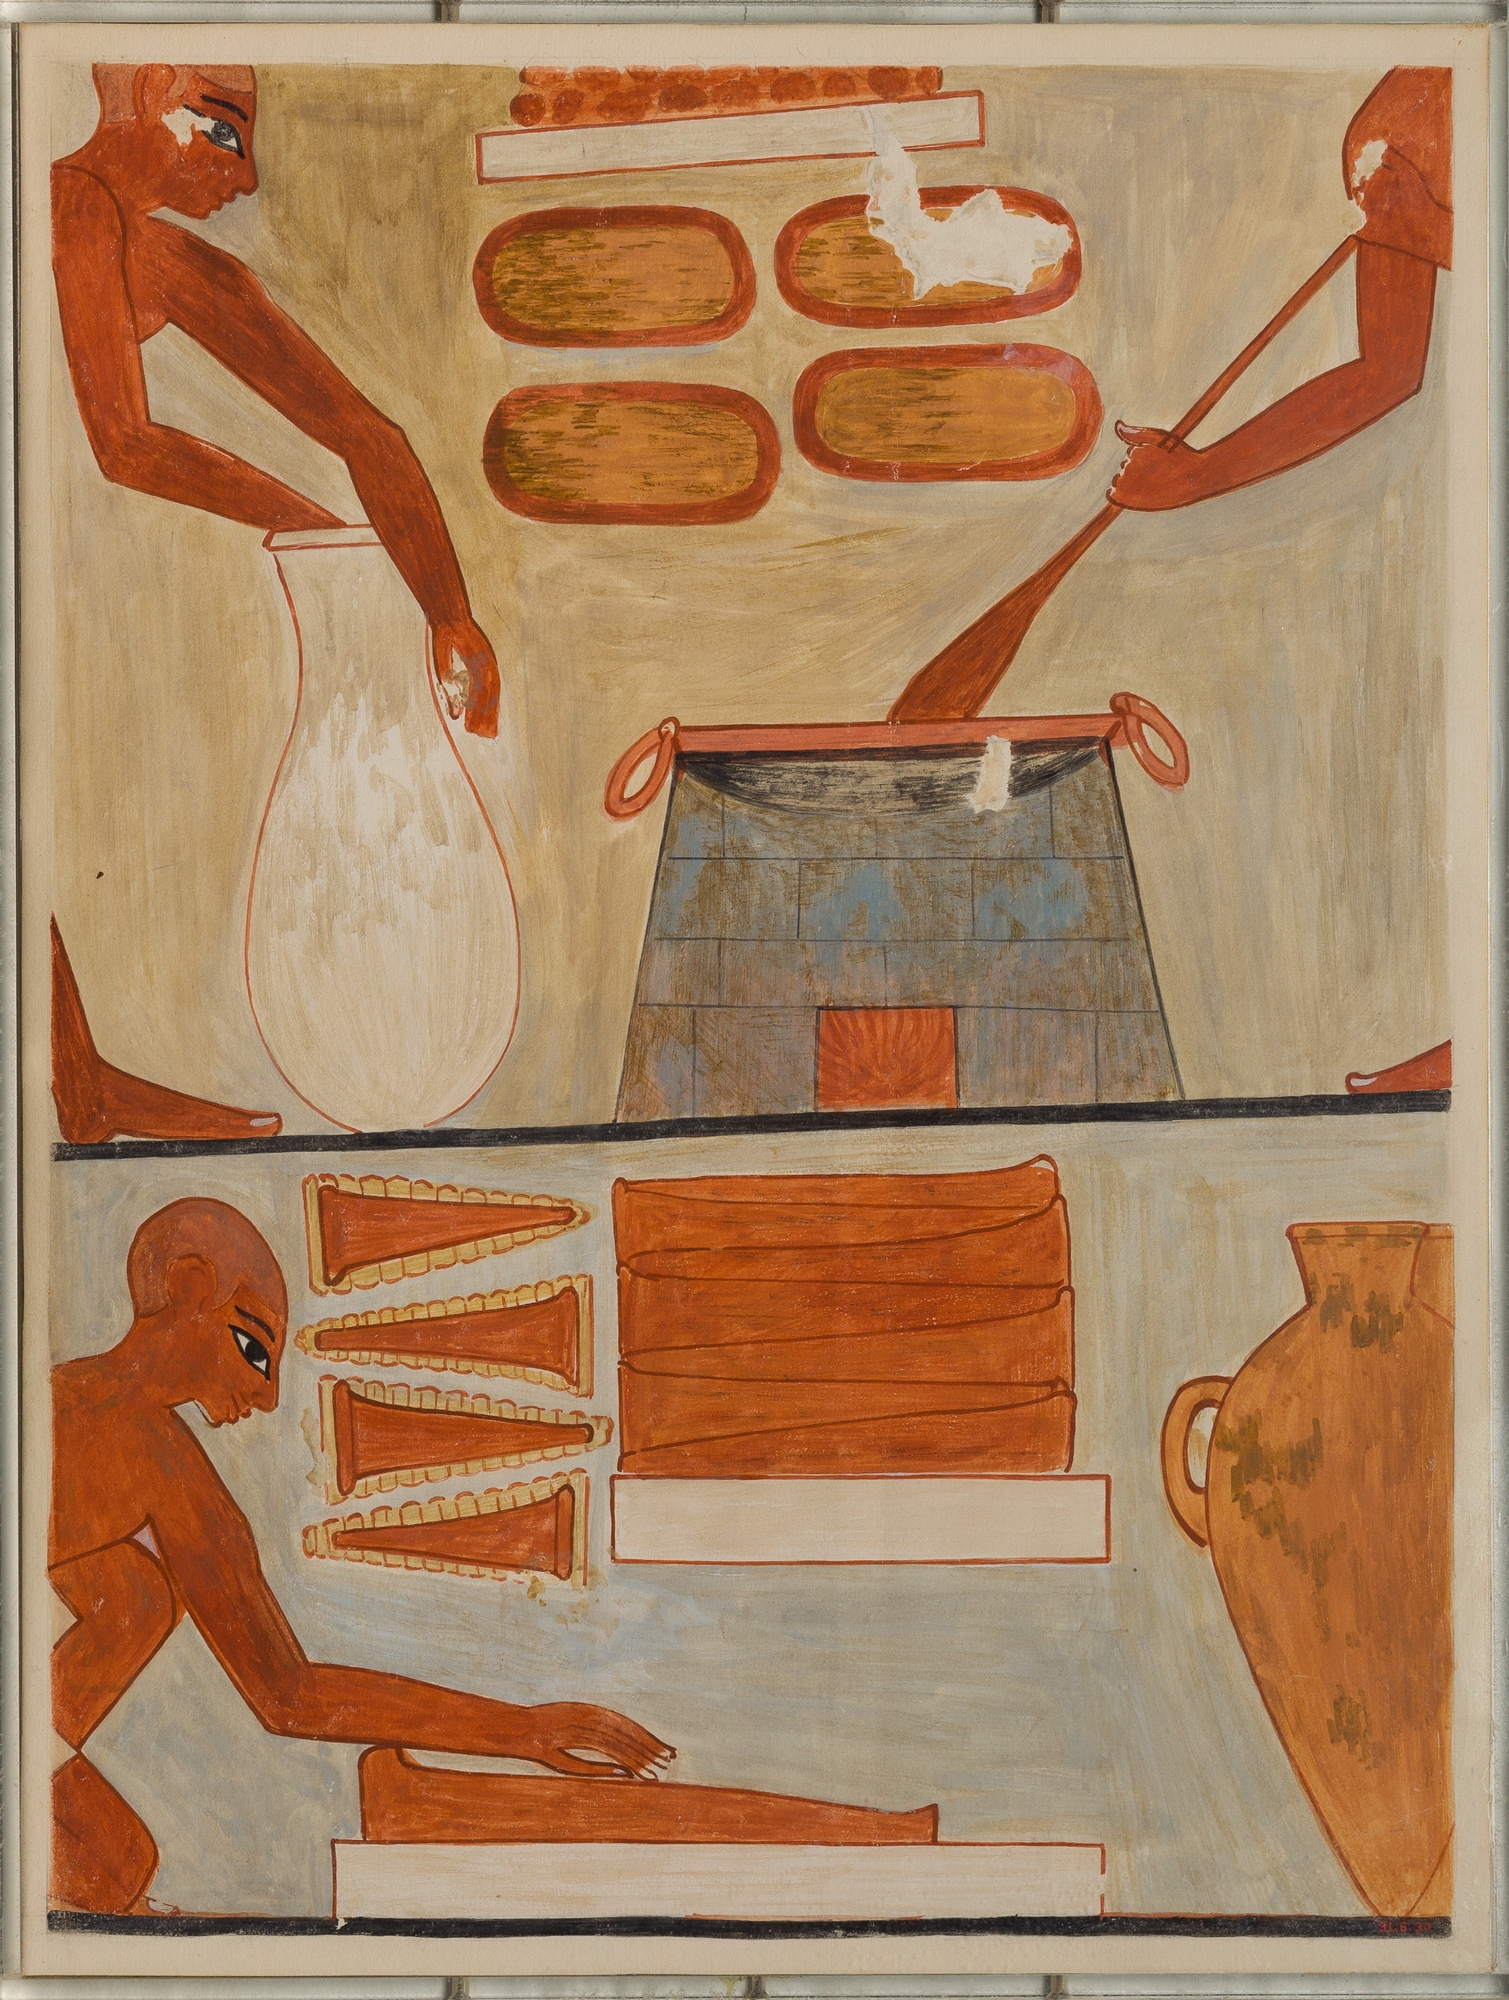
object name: facsimile, rekhmire tt 100, baker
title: Preparing and Cooking Cakes, Tomb of Rekhmire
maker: nina de garis davies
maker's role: artist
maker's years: 1881-1965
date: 1504-1425 BCE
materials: ink, paint, paper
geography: egypt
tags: food,men,cooking